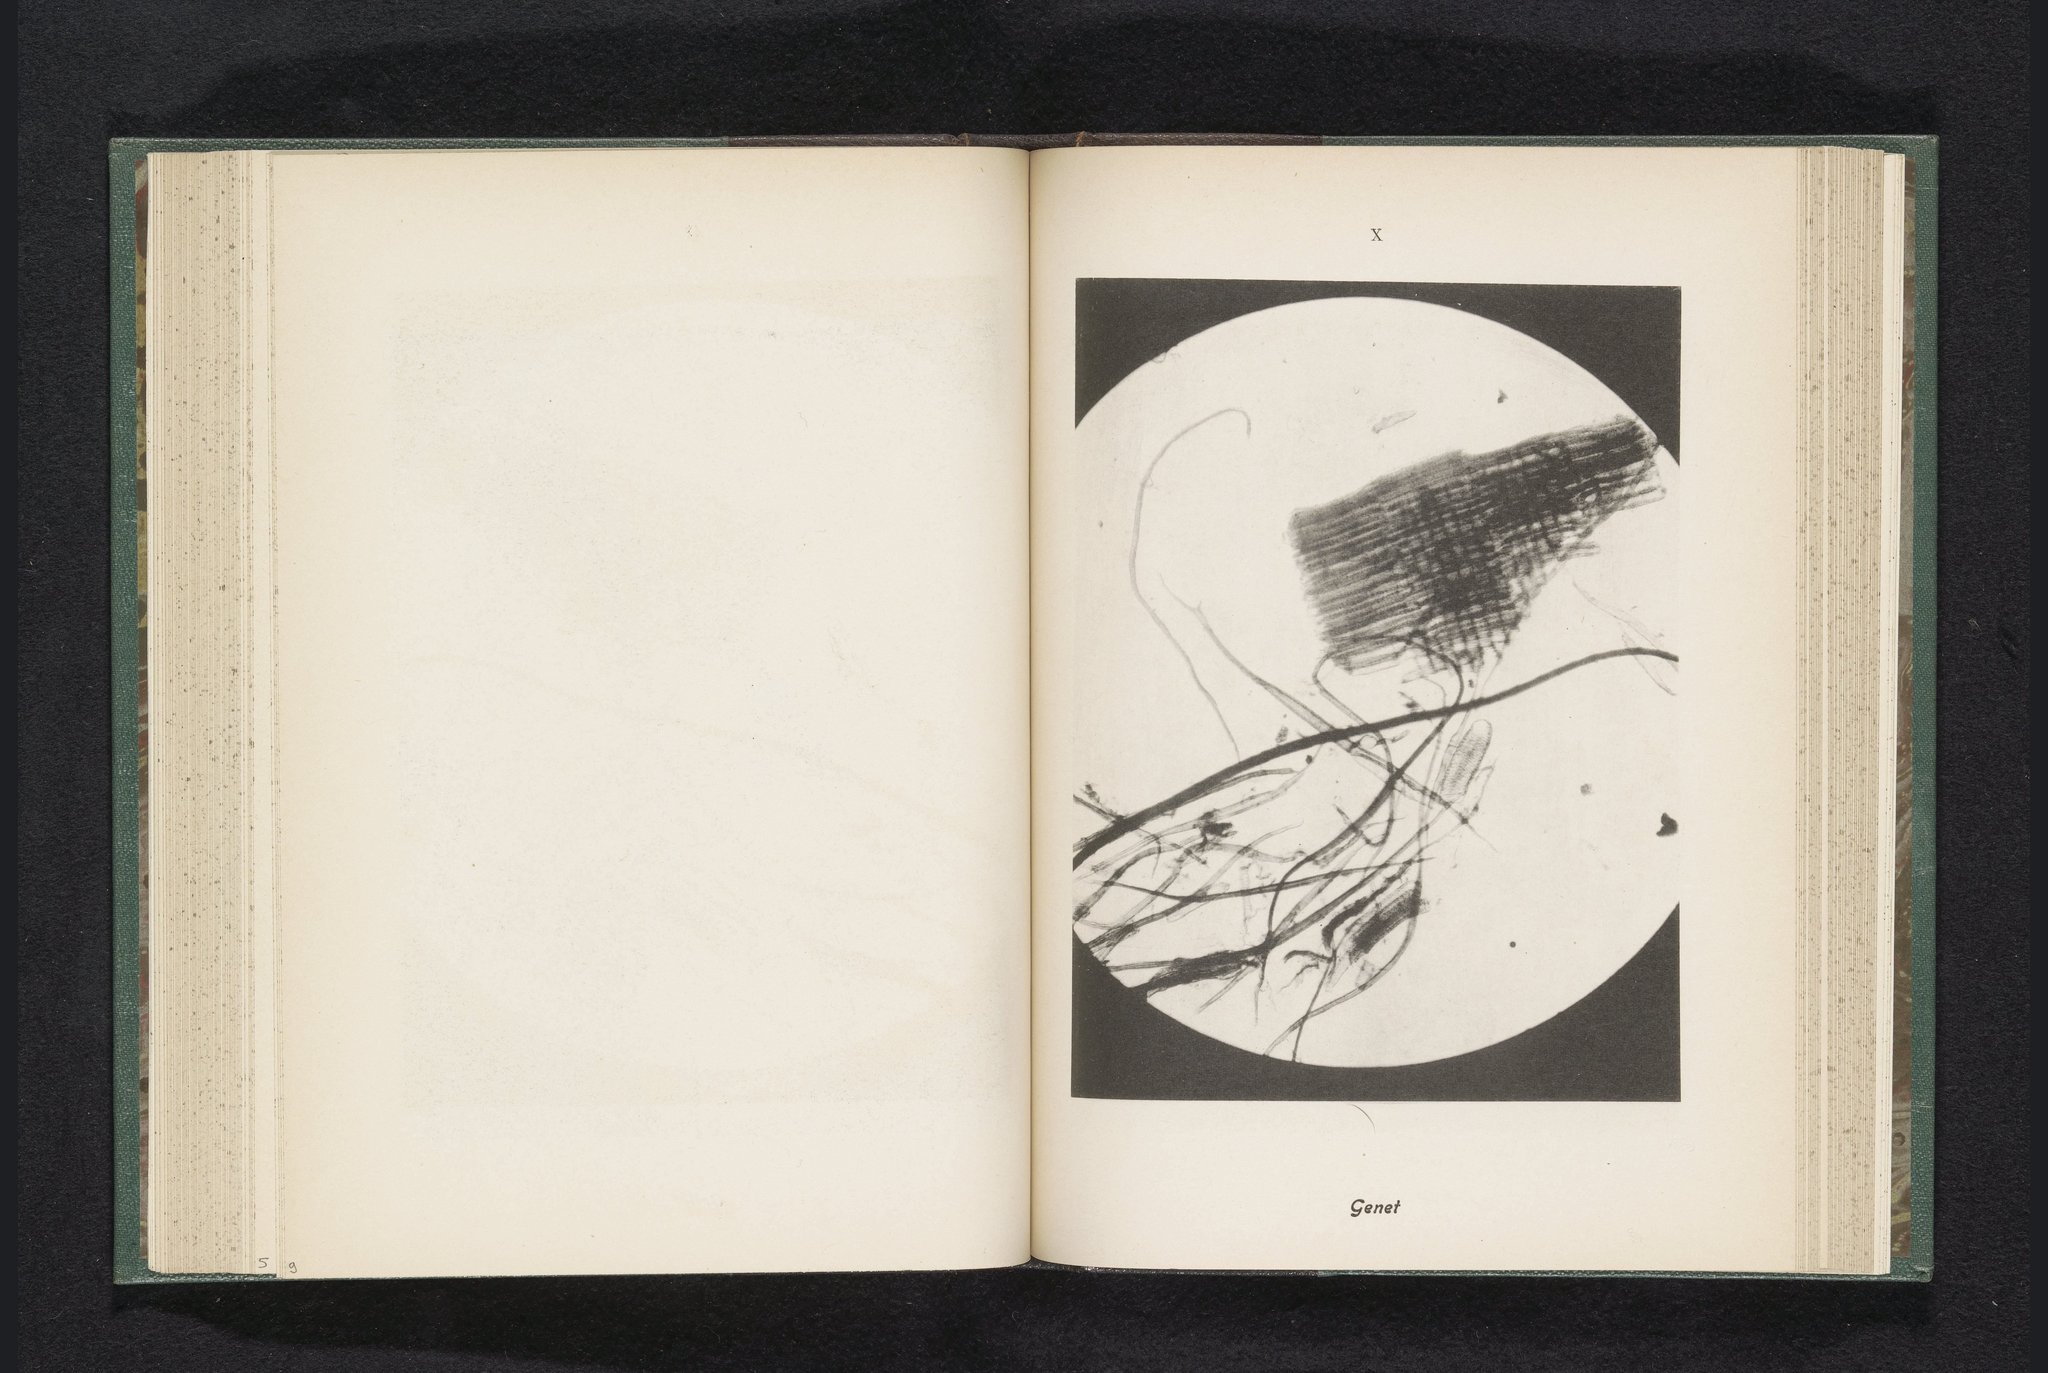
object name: photomechanical print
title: Genet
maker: Anonymous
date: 1890-1900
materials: paper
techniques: photograph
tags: microscope (+ scientific research)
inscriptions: number: ‘X’